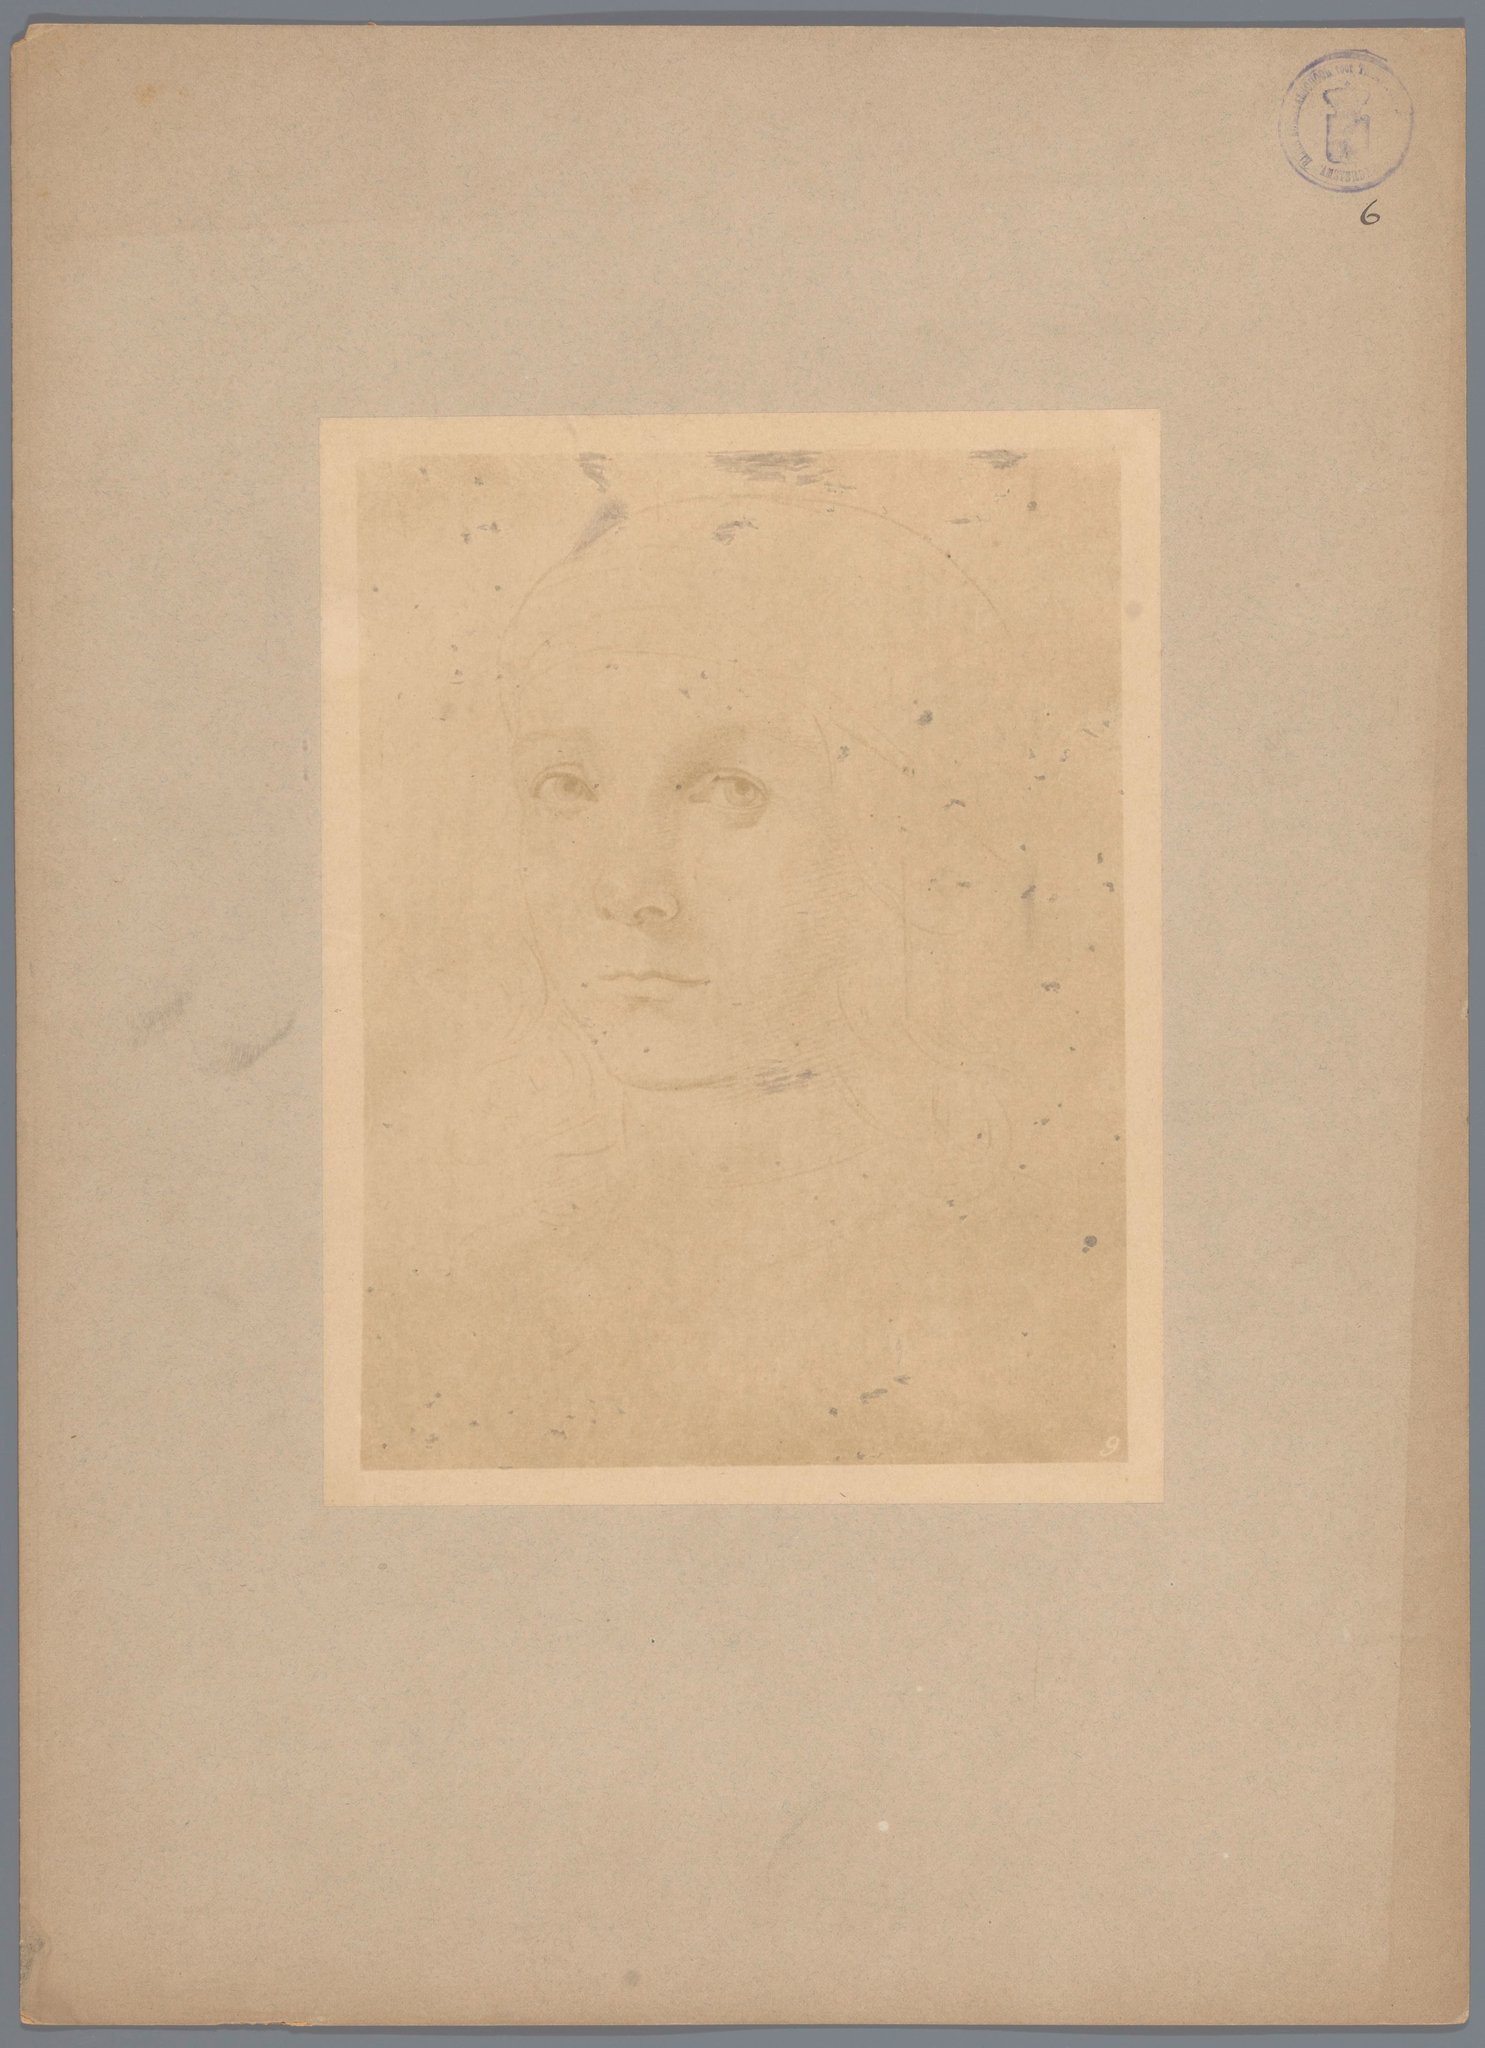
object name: reproduction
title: Fotoreproductie van een schets, voorstellende een portret van een man met een hoed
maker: Anonymous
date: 1875-1900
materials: cardboard, photographic support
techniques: albumen print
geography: europe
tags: head-gear: hat, anonymous historical person portrayed, europe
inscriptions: collector's mark: ‘RIJKS-NORMAALSCHOOL voor TEEKENONDERWIJZERS AMSTERDAM’, collector's mark: ‘RIJKS-NORMAALSCHOOL voor TEEKENONDERWIJZERS AMSTERDAM’, number: ‘9’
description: Arceringen in potlood zijn zichtbaar op het beeldvlak.